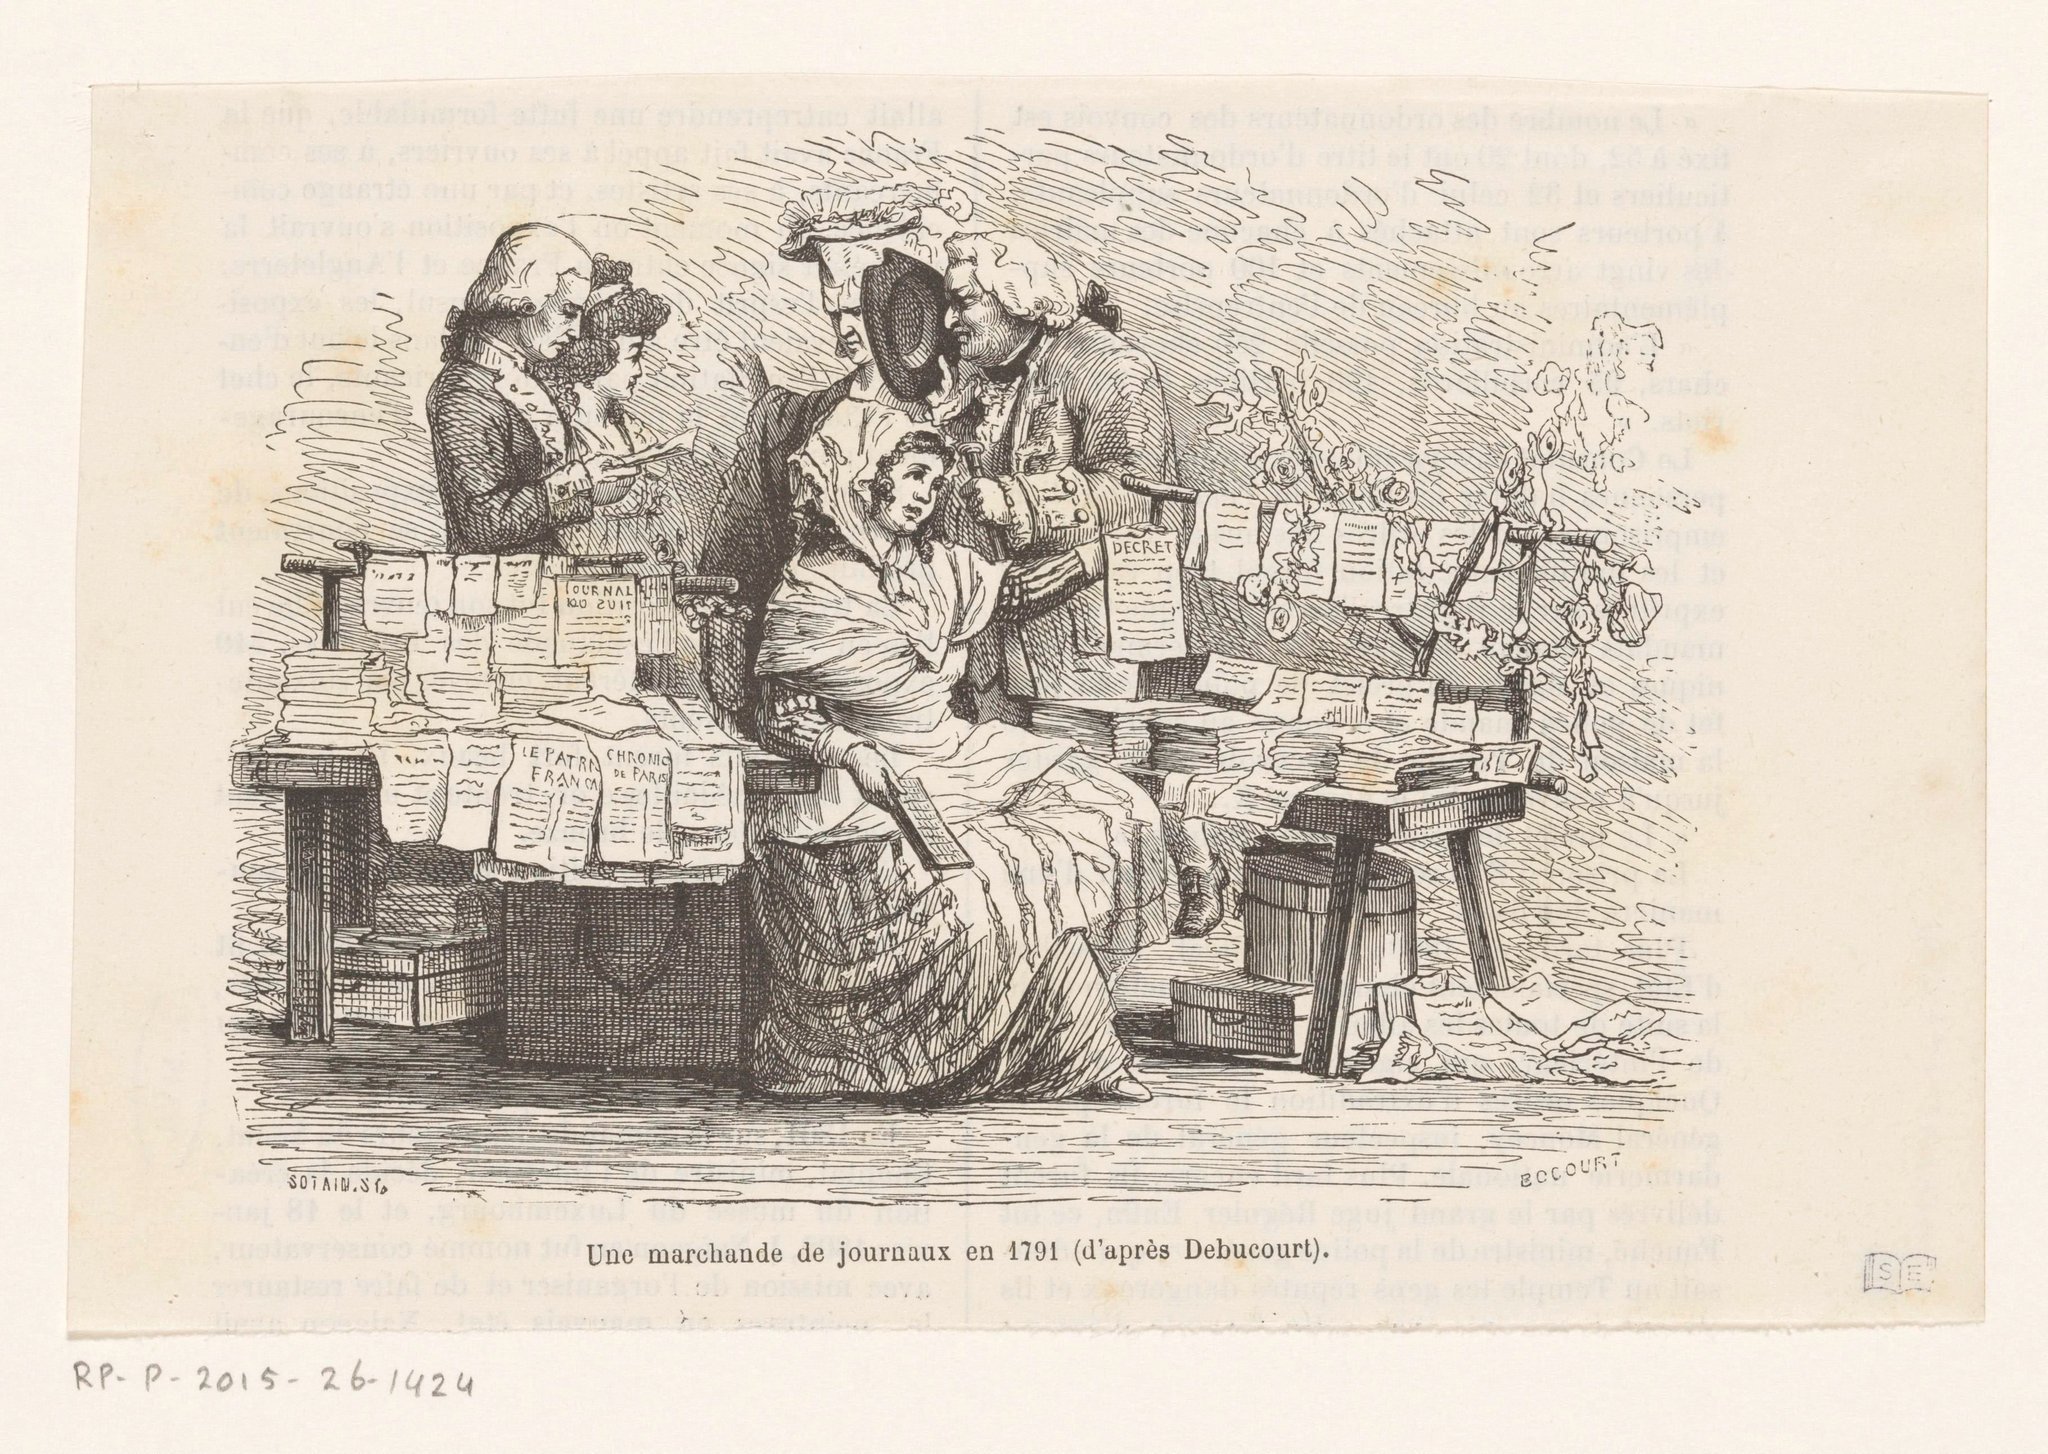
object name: print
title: Verkoopster van kranten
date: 1831-1874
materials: paper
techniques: engraving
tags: reading, sale of newspaper, newspaper stand, street-trader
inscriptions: collector's mark: Lugt 2228, collector's mark: Lugt 4780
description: Kraampje van een vrouw die kranten verkoopt. Vier mannen en vrouwen in achttiende-eeuwse kleding bekijken het aanbod. Tekst op verso.